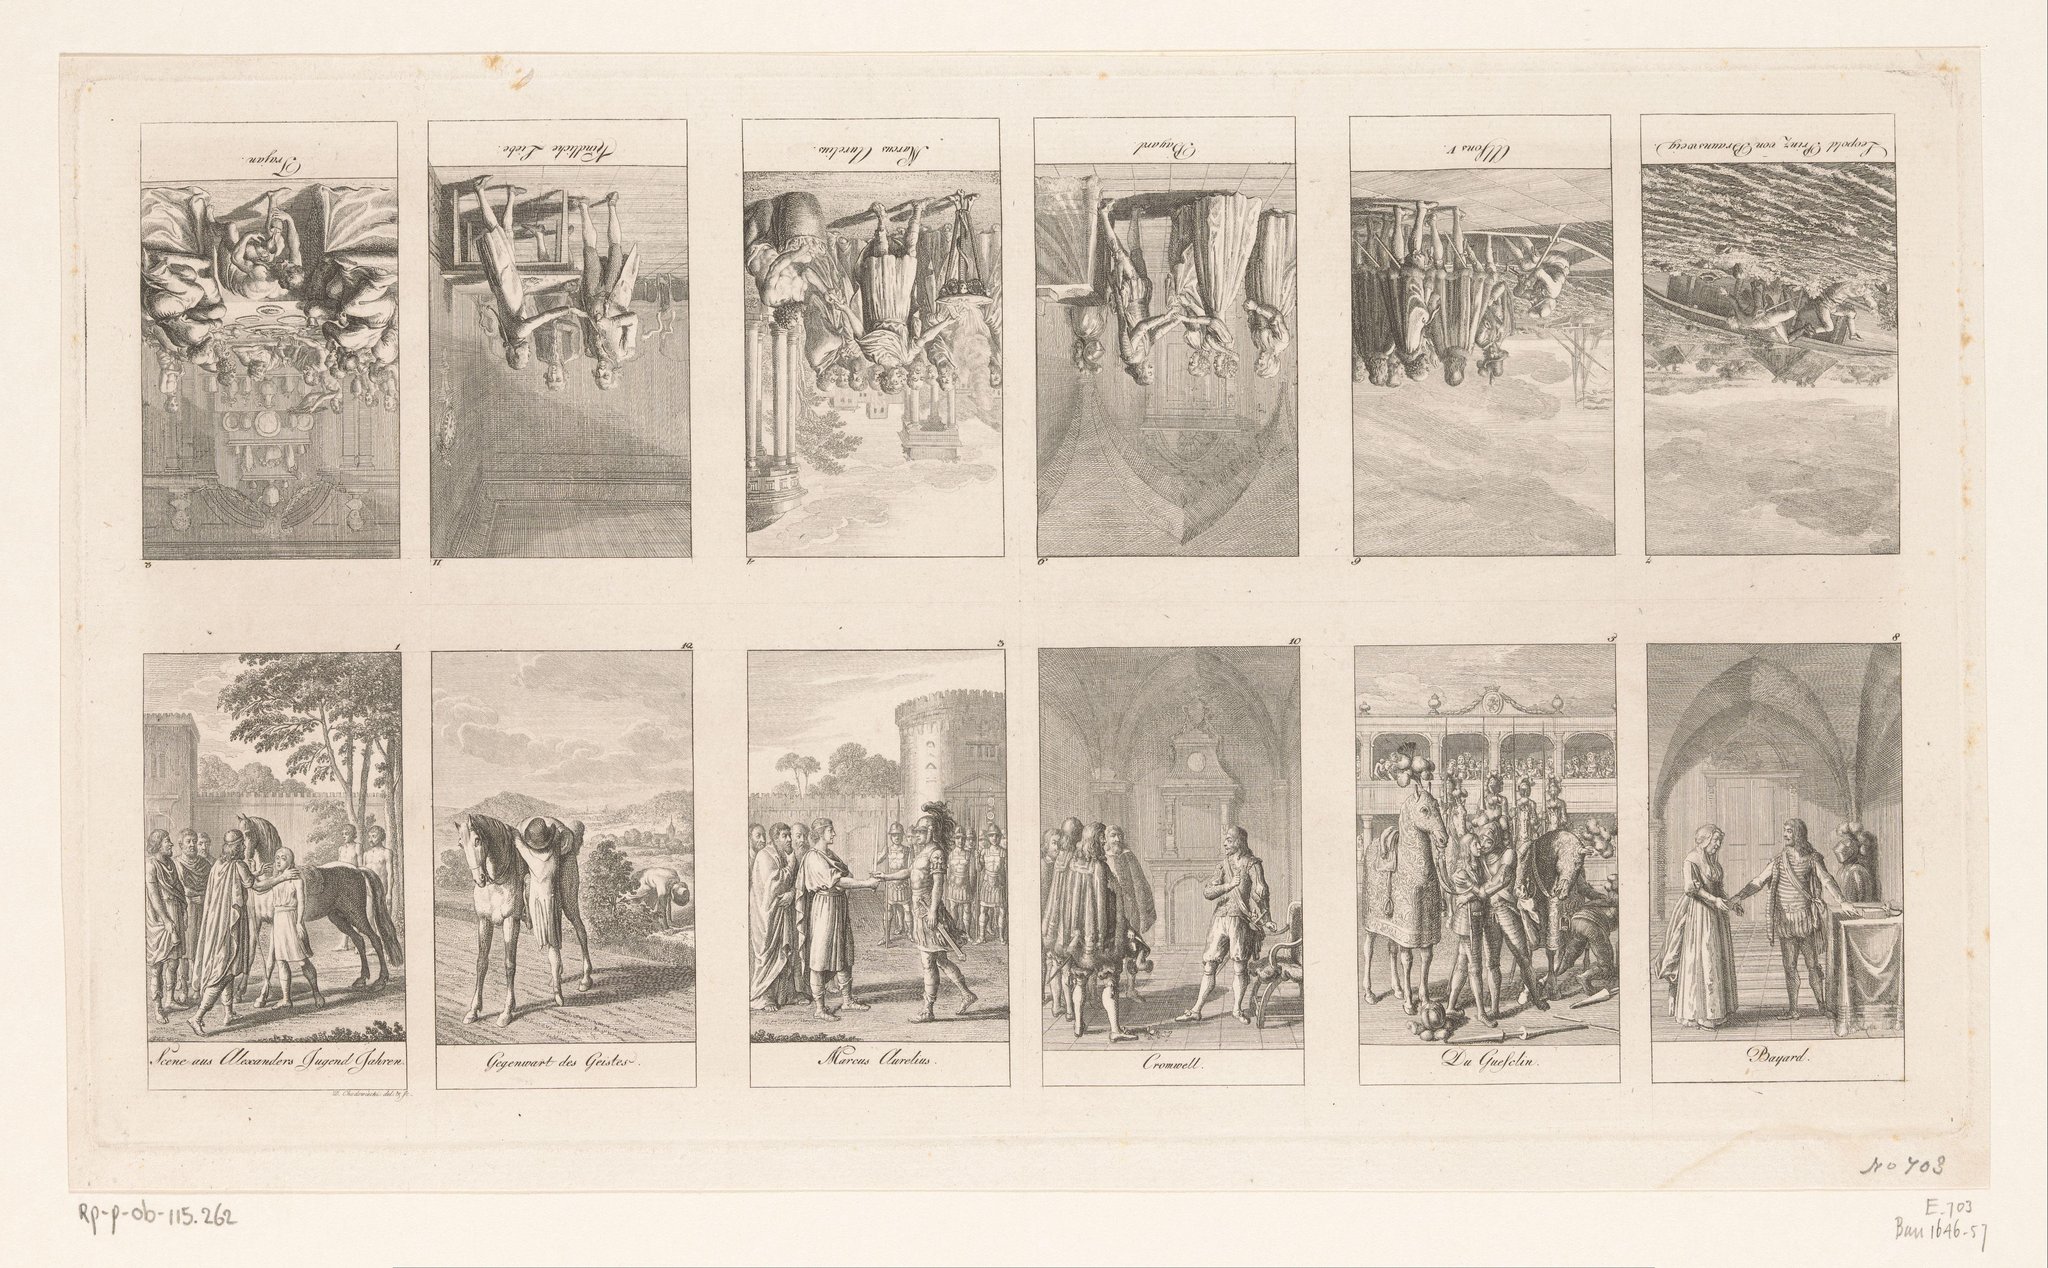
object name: print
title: Twaalf voorstellingen uit de oudste, middelste en nieuwste geschiedenis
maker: daniel nikolaus chodowiecki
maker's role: draughtsman, print maker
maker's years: 1726-1801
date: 1793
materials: paper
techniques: etching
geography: berlin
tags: pierre du terrail de bayard, rome, london, oliver cromwell, naples, history, (story of) the emperor trajan, shipwreck, robber, (story of) alexander the great, joust, tilt, ruler, sovereign, horse, (story of) marcus aurelius, the roman emperor, death by drowning (non-violent)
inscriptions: collector's mark: Lugt 2228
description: Prenten gebruikt voor: Genealogischen Calender zur angenehmen und nützlichen Unterhaltung auf das Jahr 1794. Berlijn: Königl. Akademie der Wissenschaften, [1793].